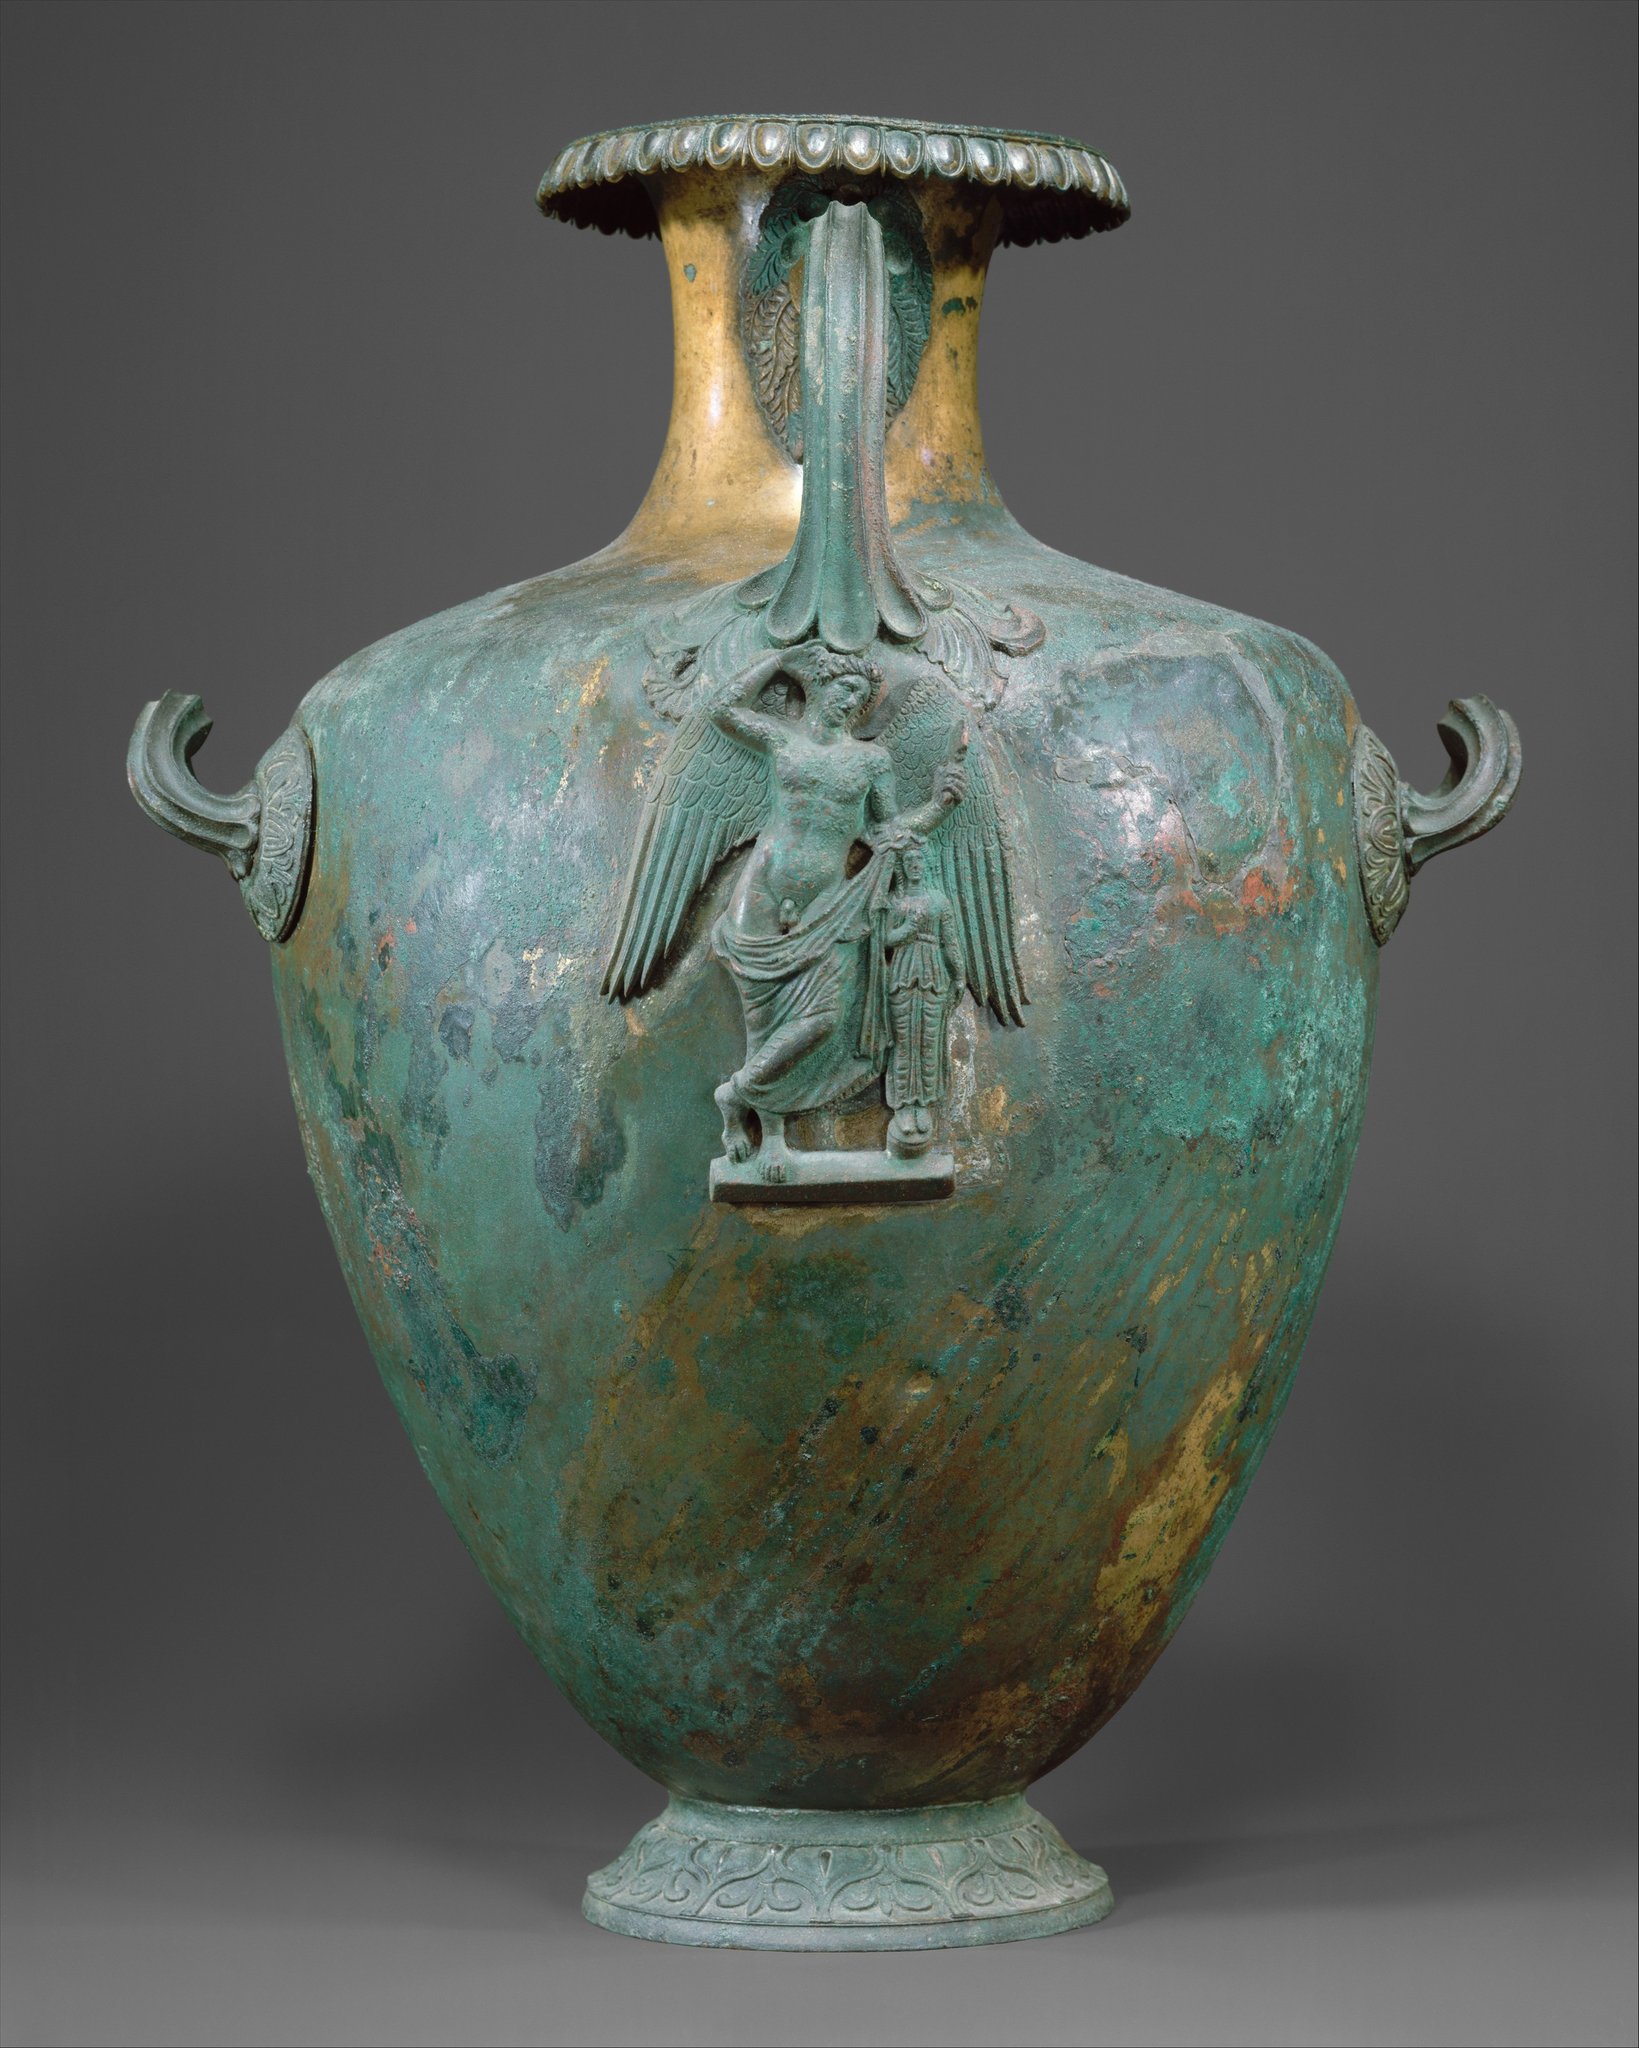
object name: hydria with eros on handle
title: Bronze hydria (water jar)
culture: greek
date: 400-301 BCE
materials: bronze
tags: women,eros,mirrors